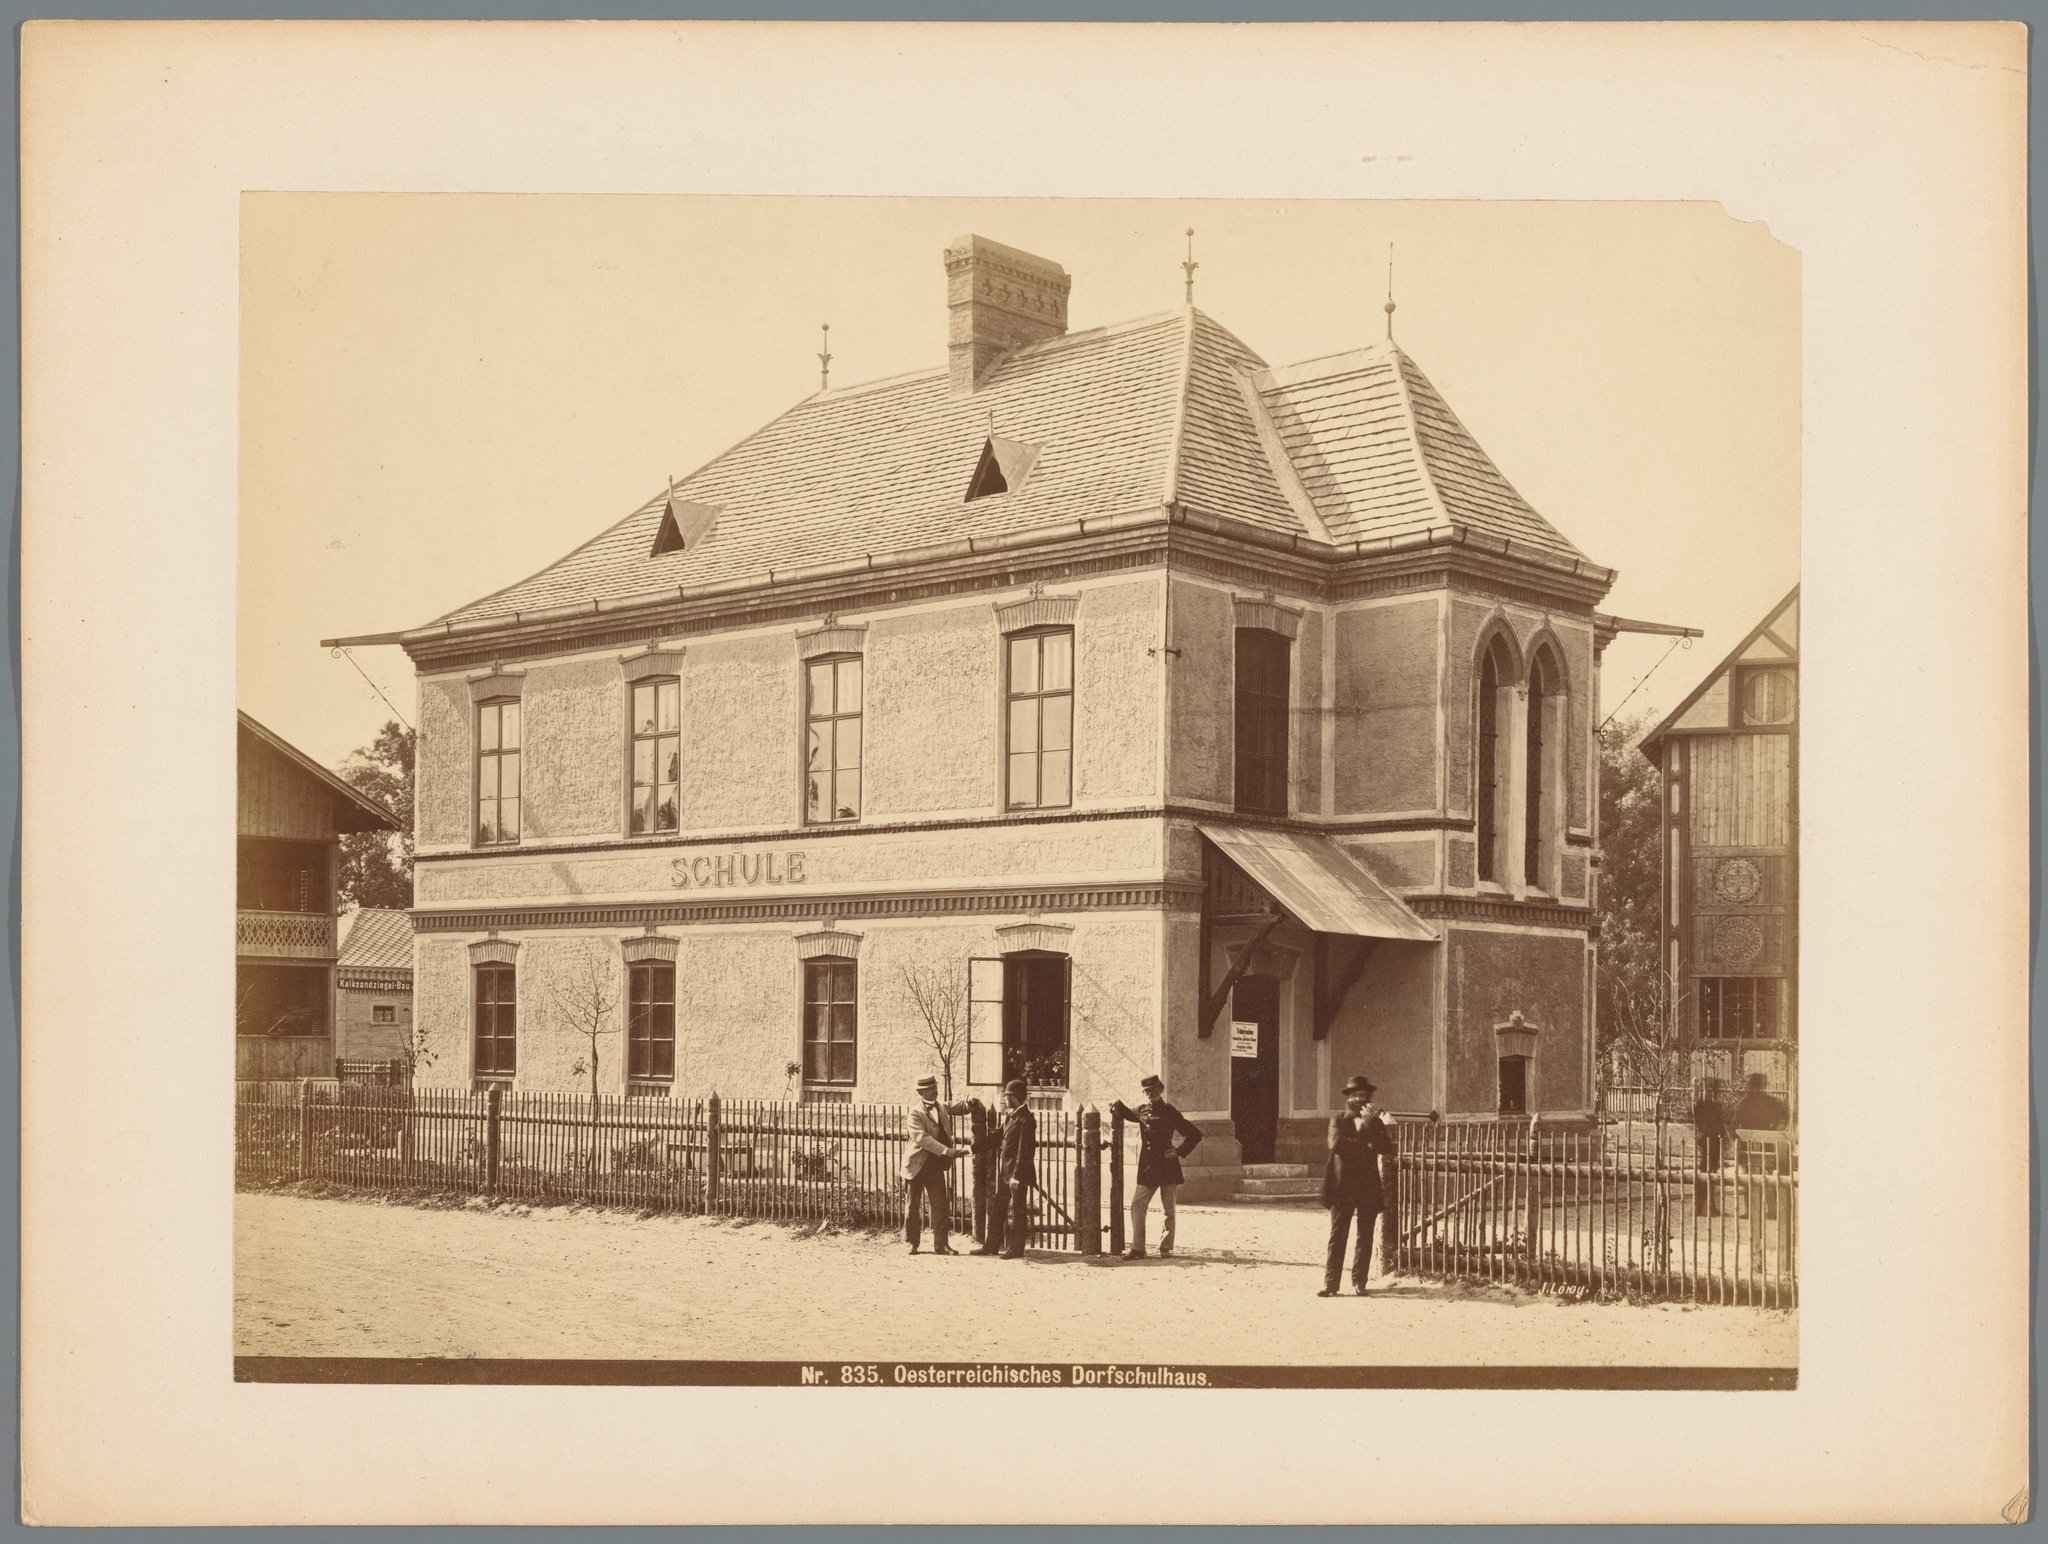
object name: photograph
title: Vier mannen poserend voor een Oostenrijkse dorpsschool op de Wereldtentoonstelling van 1873 te Wenen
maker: josef löwy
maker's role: publisher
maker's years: 1835-1902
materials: cardboard, photographic support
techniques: albumen print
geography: vienna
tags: non-aggressive relationships, world fair, world exhibition, fence, wall, paling, vienna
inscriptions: collector's mark: Lugt 3937, number: ‘Nr. 835.’